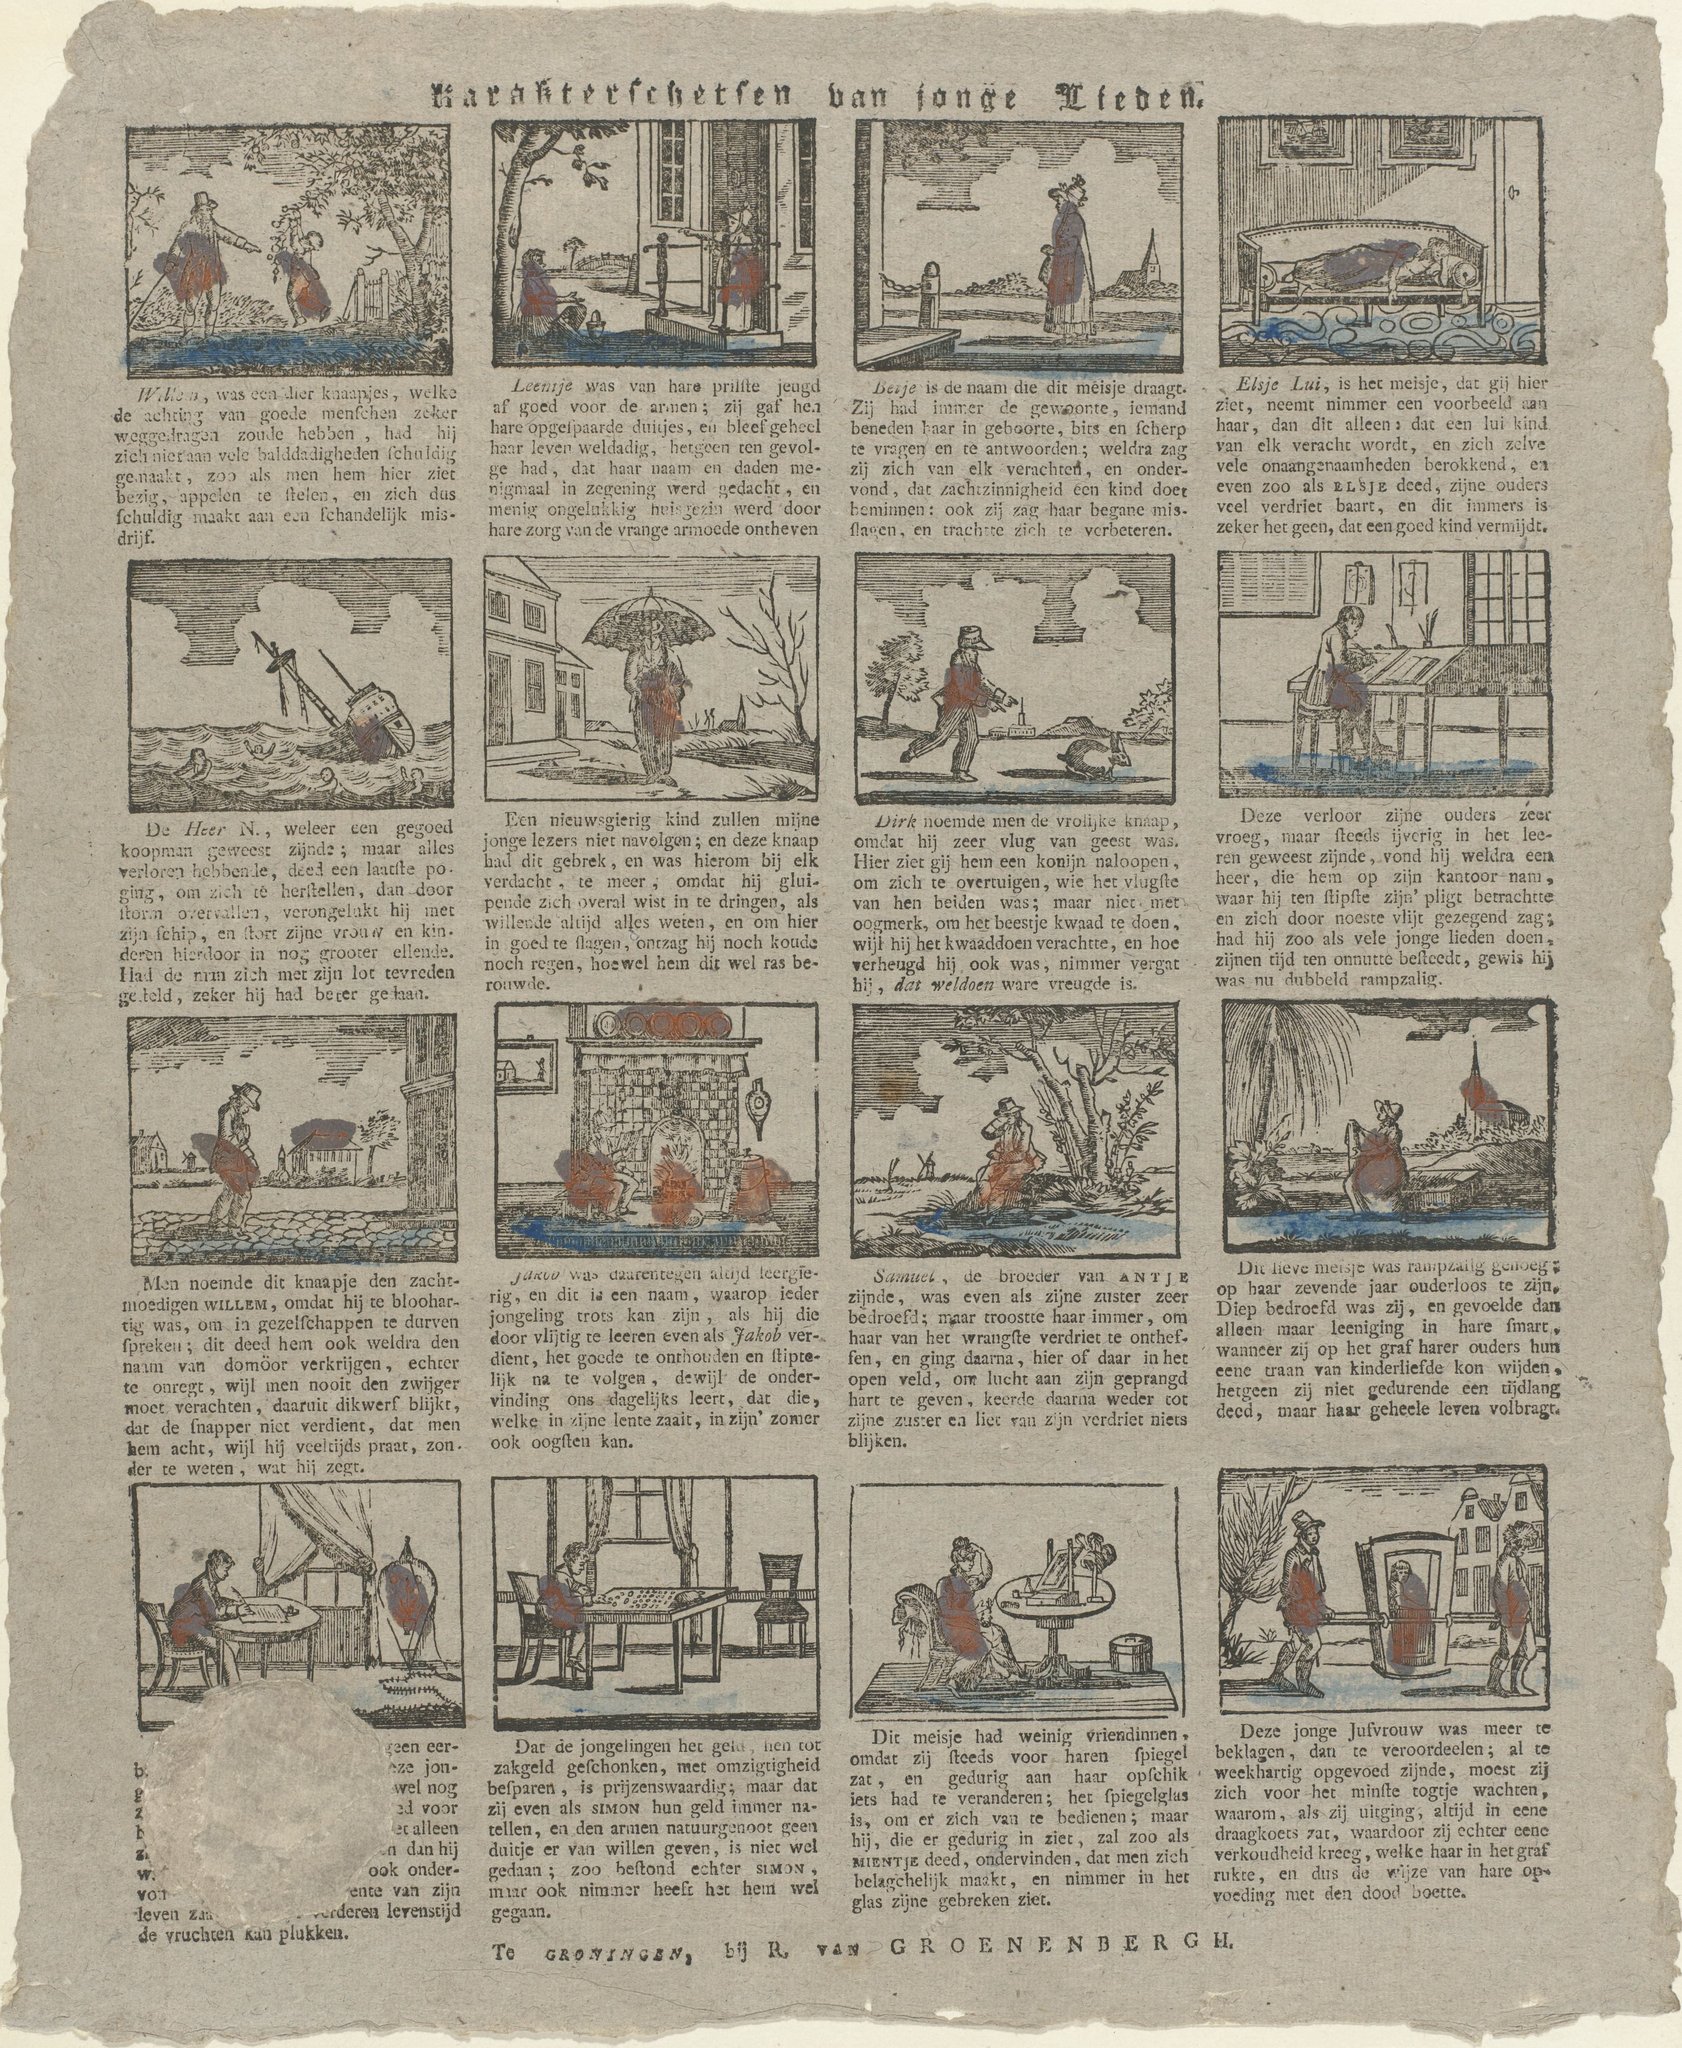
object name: popular print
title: Karakterschetsen van jonge lieden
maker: rudolph van groenenbergh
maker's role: bookseller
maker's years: 1784-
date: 1810-1822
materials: paper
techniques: letterpress printing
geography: groningen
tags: feeling, emotion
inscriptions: collector's mark: Lugt 2760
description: Blad met 16 voorstellingen van jongeren in verschillende gemoedstoestanden, waaronder een luie meid, een nieuwgierig kind en een bedroefde jongen. Onder elke voorstelling negen regels tekst.